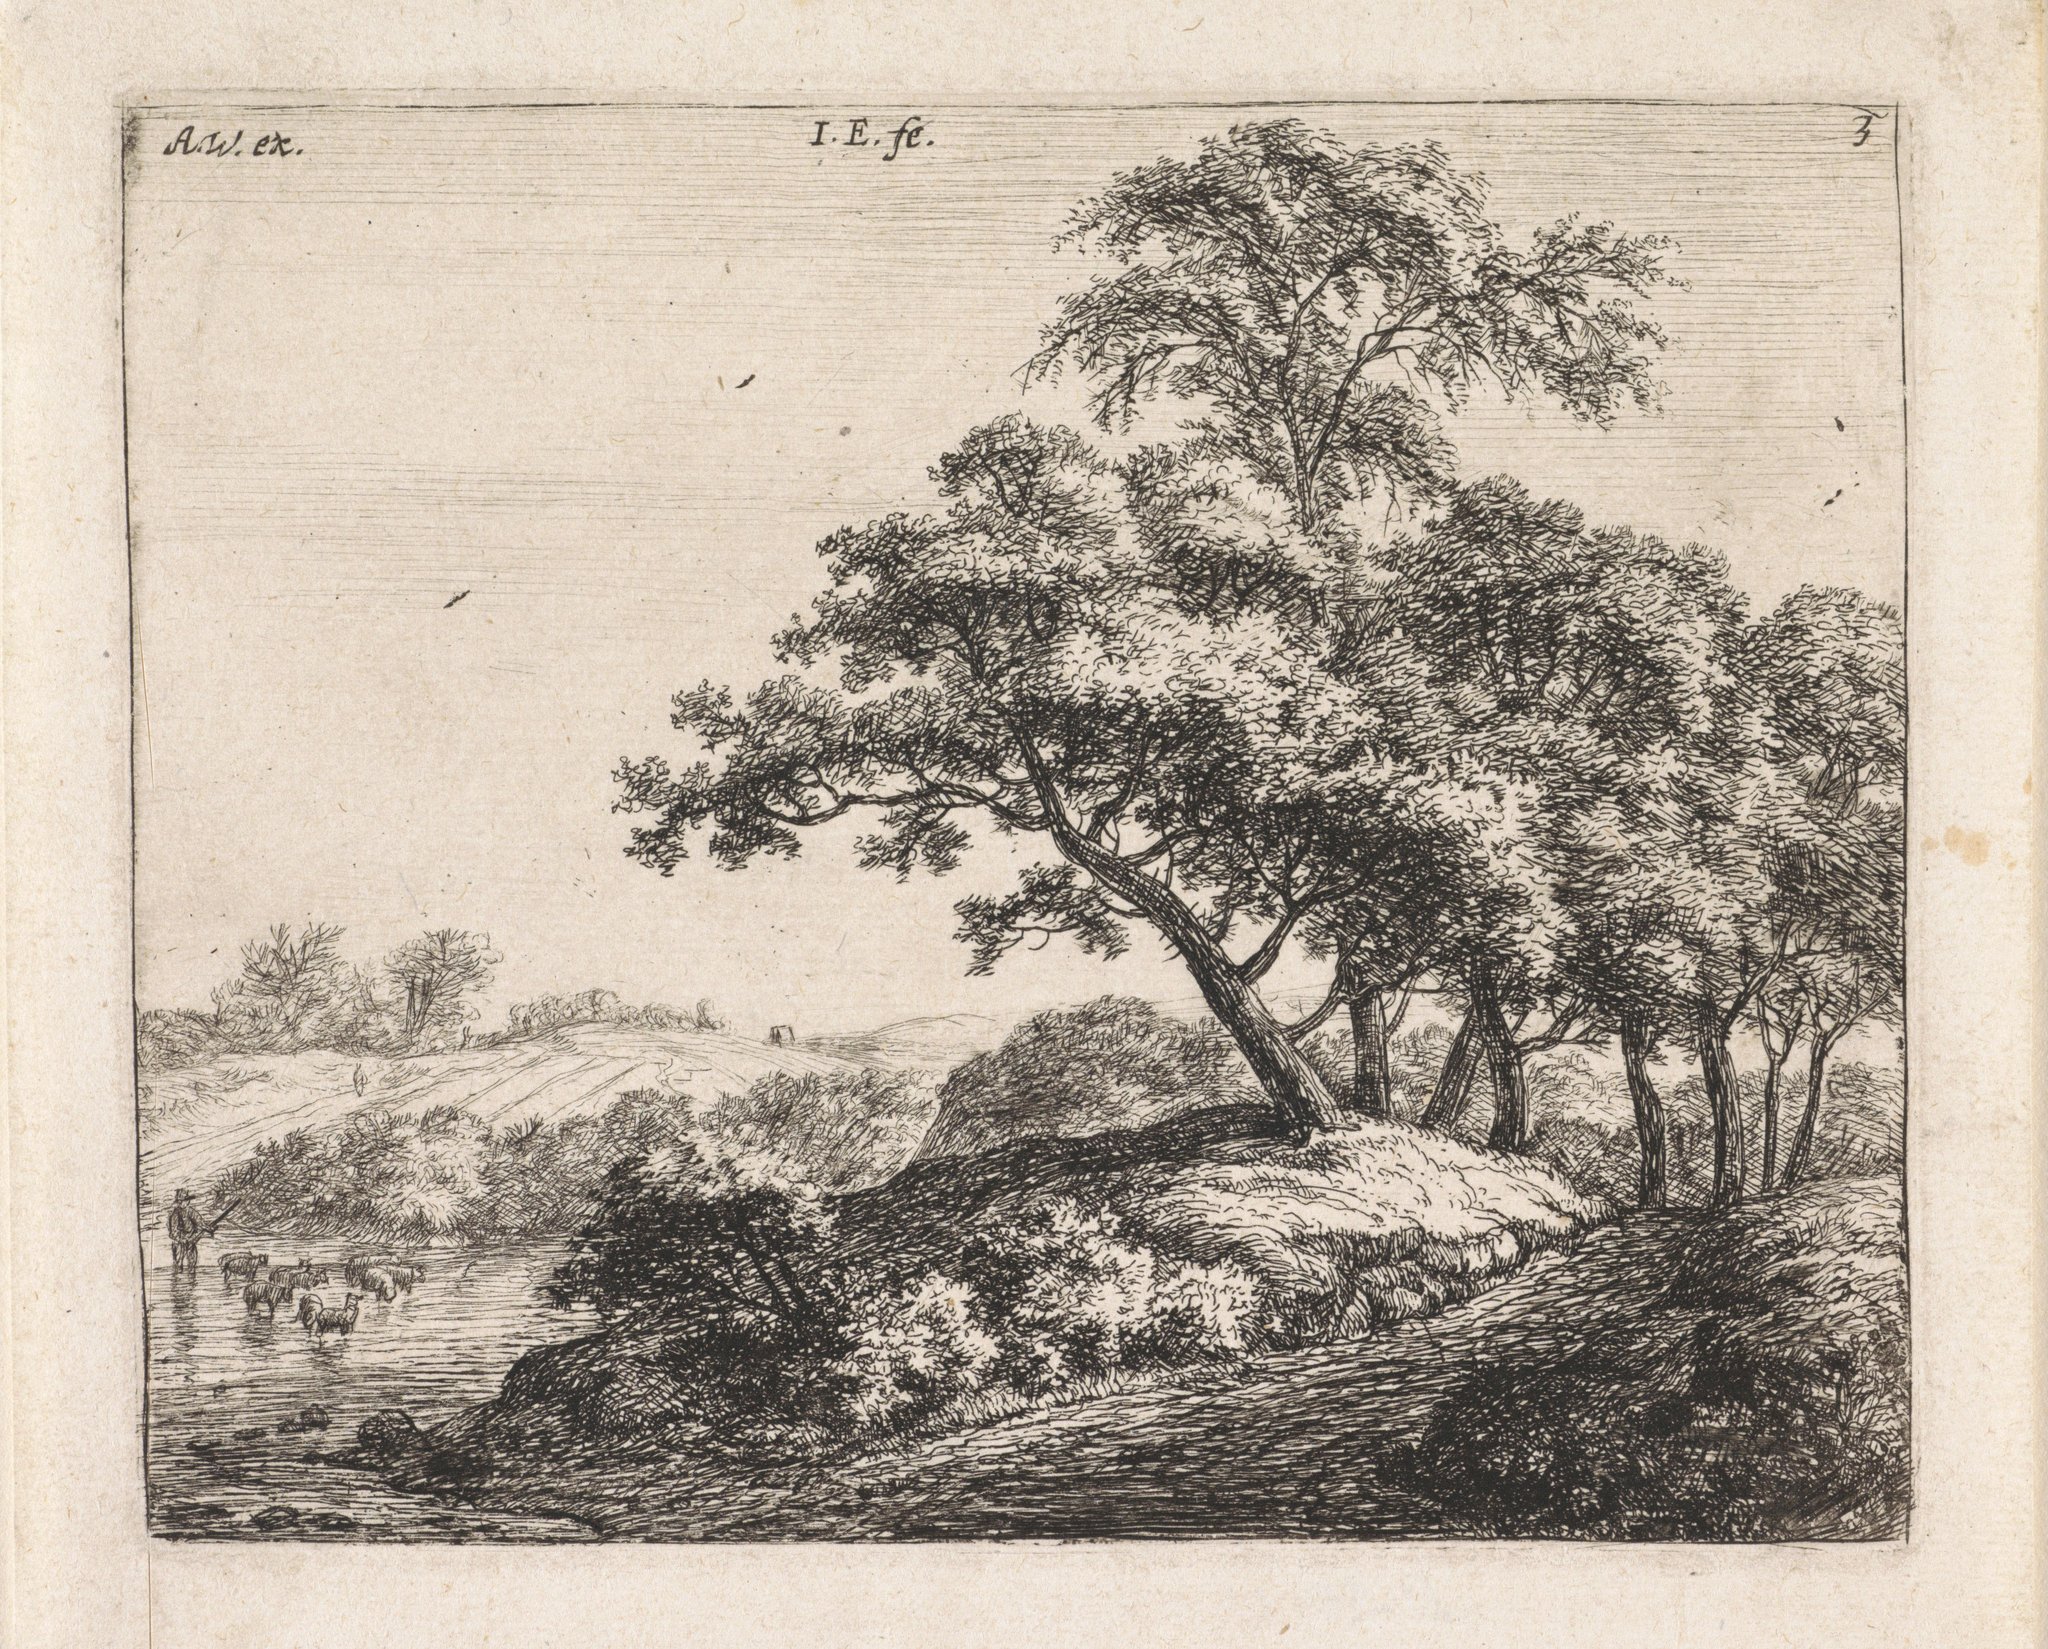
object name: print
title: Kudde schapen in een rivier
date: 1646-1663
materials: paper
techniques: etching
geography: amsterdam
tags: river, herding, herdsman, herdswoman, shepherd, shepherdess, cowherd, etc., forest, wood, sheep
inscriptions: collector's mark: Lugt 240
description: Rechts een bospad door een glooiend landschap. Links in de verte waadt een herder met zijn kudde schapen door een rivier.